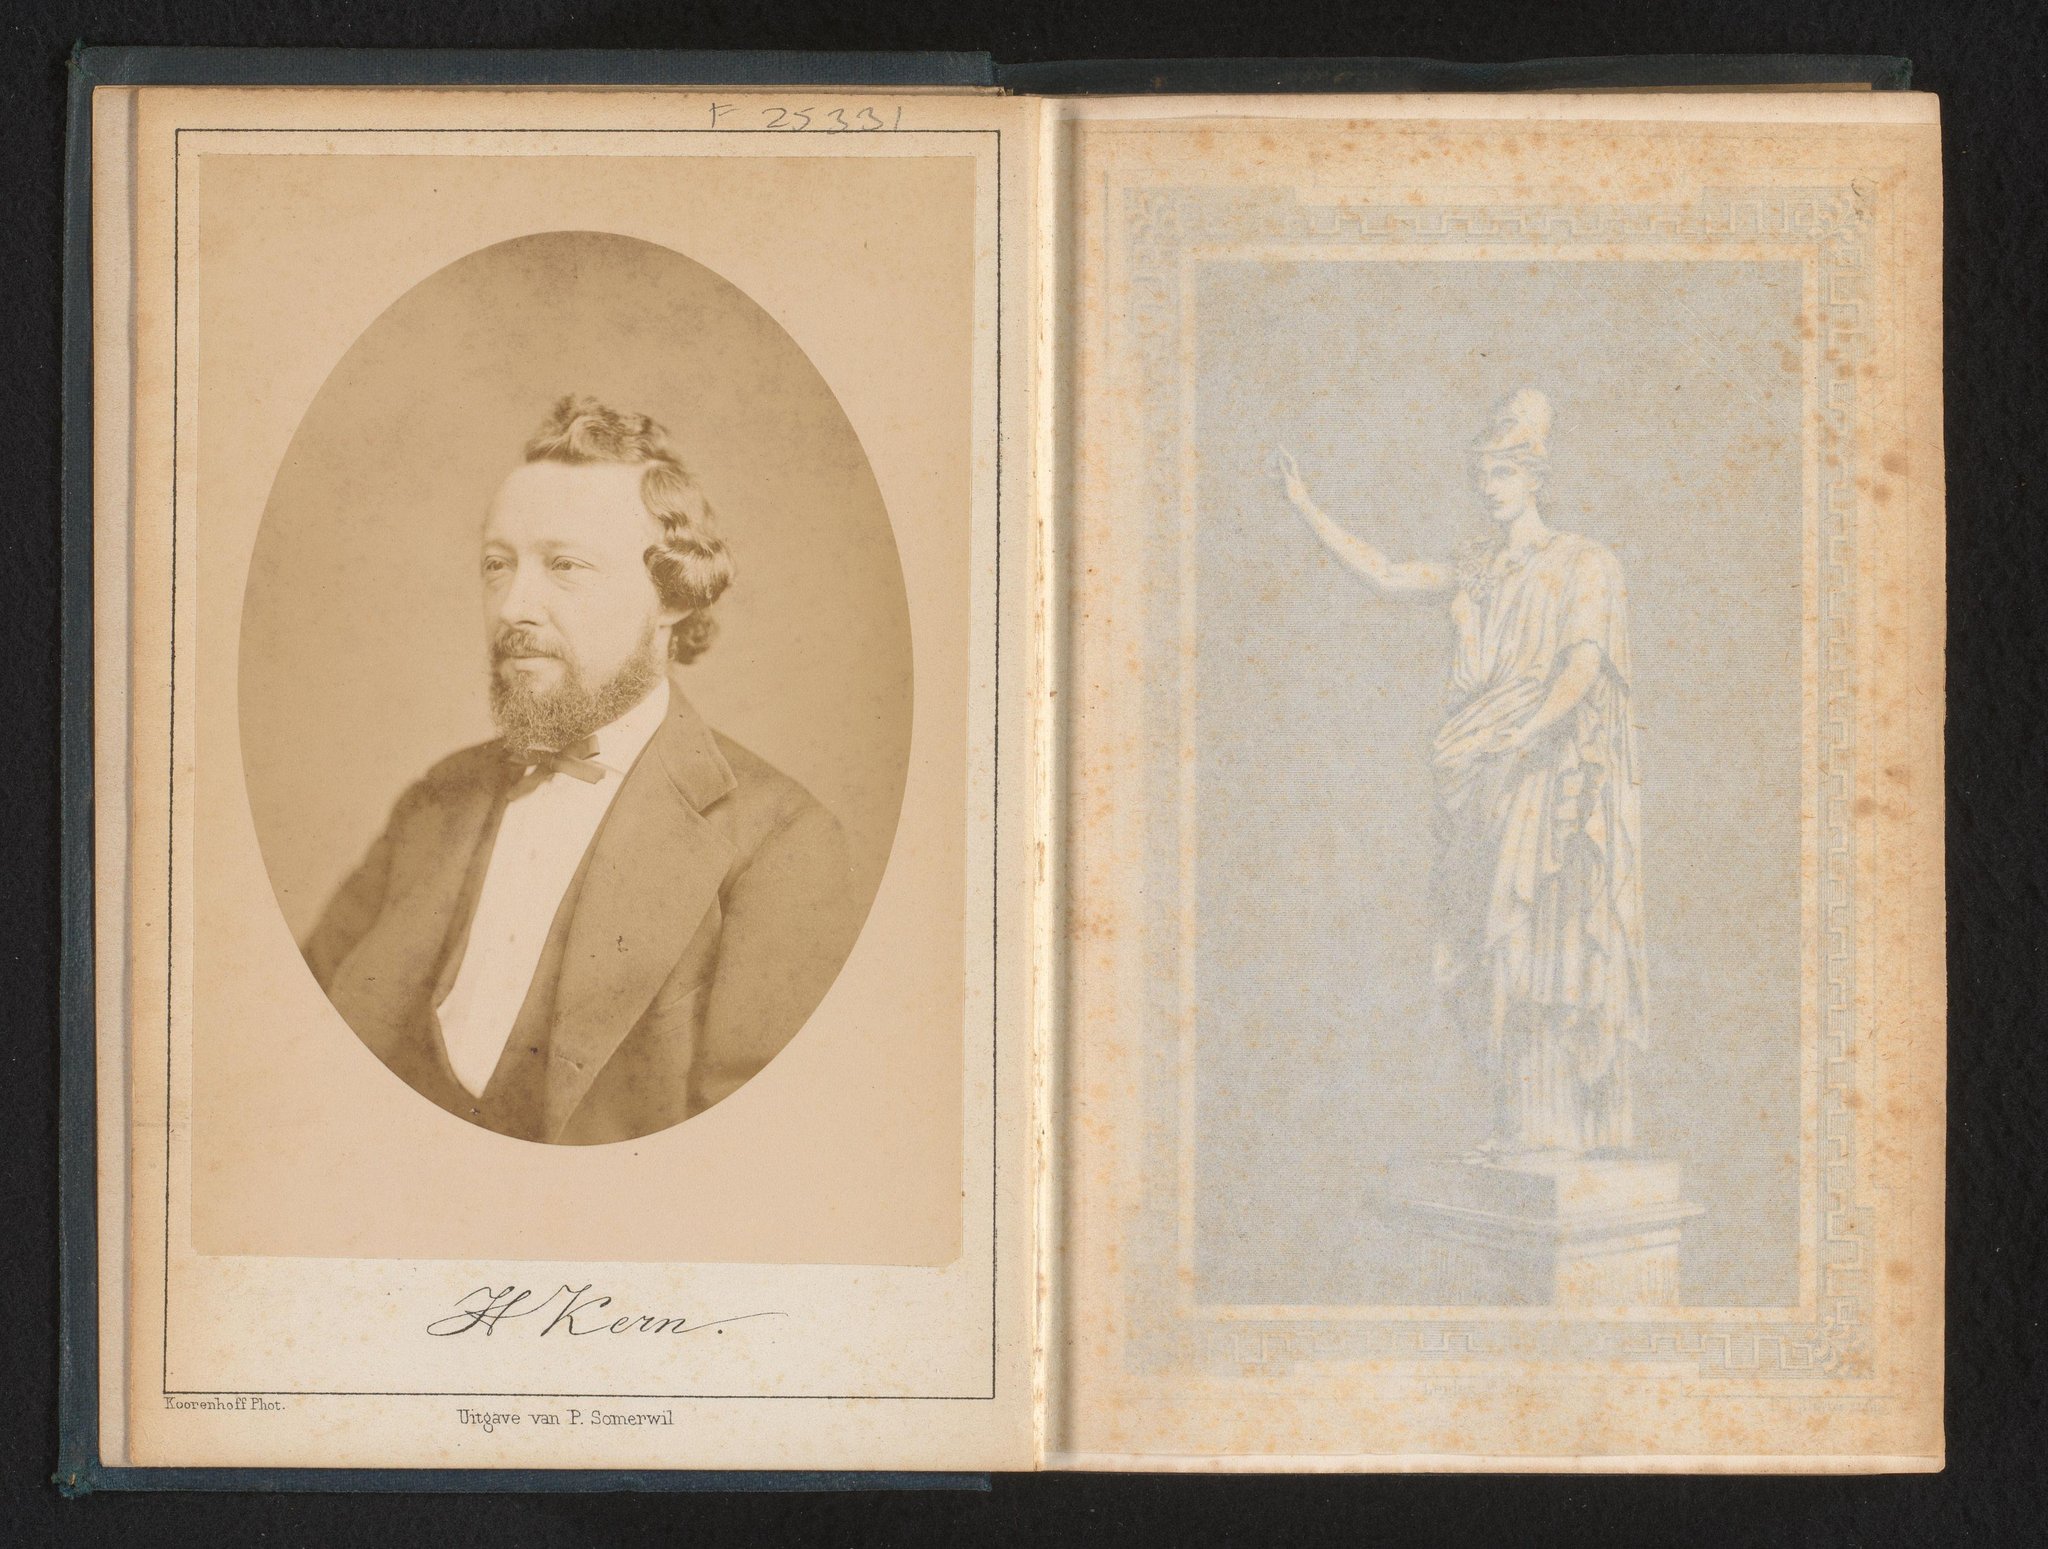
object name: page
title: Portret van Hendrik Kern, hoogleraar wijsbegeerte en letteren en rector magnificus van de Universiteit Leiden 1879-1880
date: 1878-1879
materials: paper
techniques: albumen print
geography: leiden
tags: historical persons, professor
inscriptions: signature: ‘H. Kern’